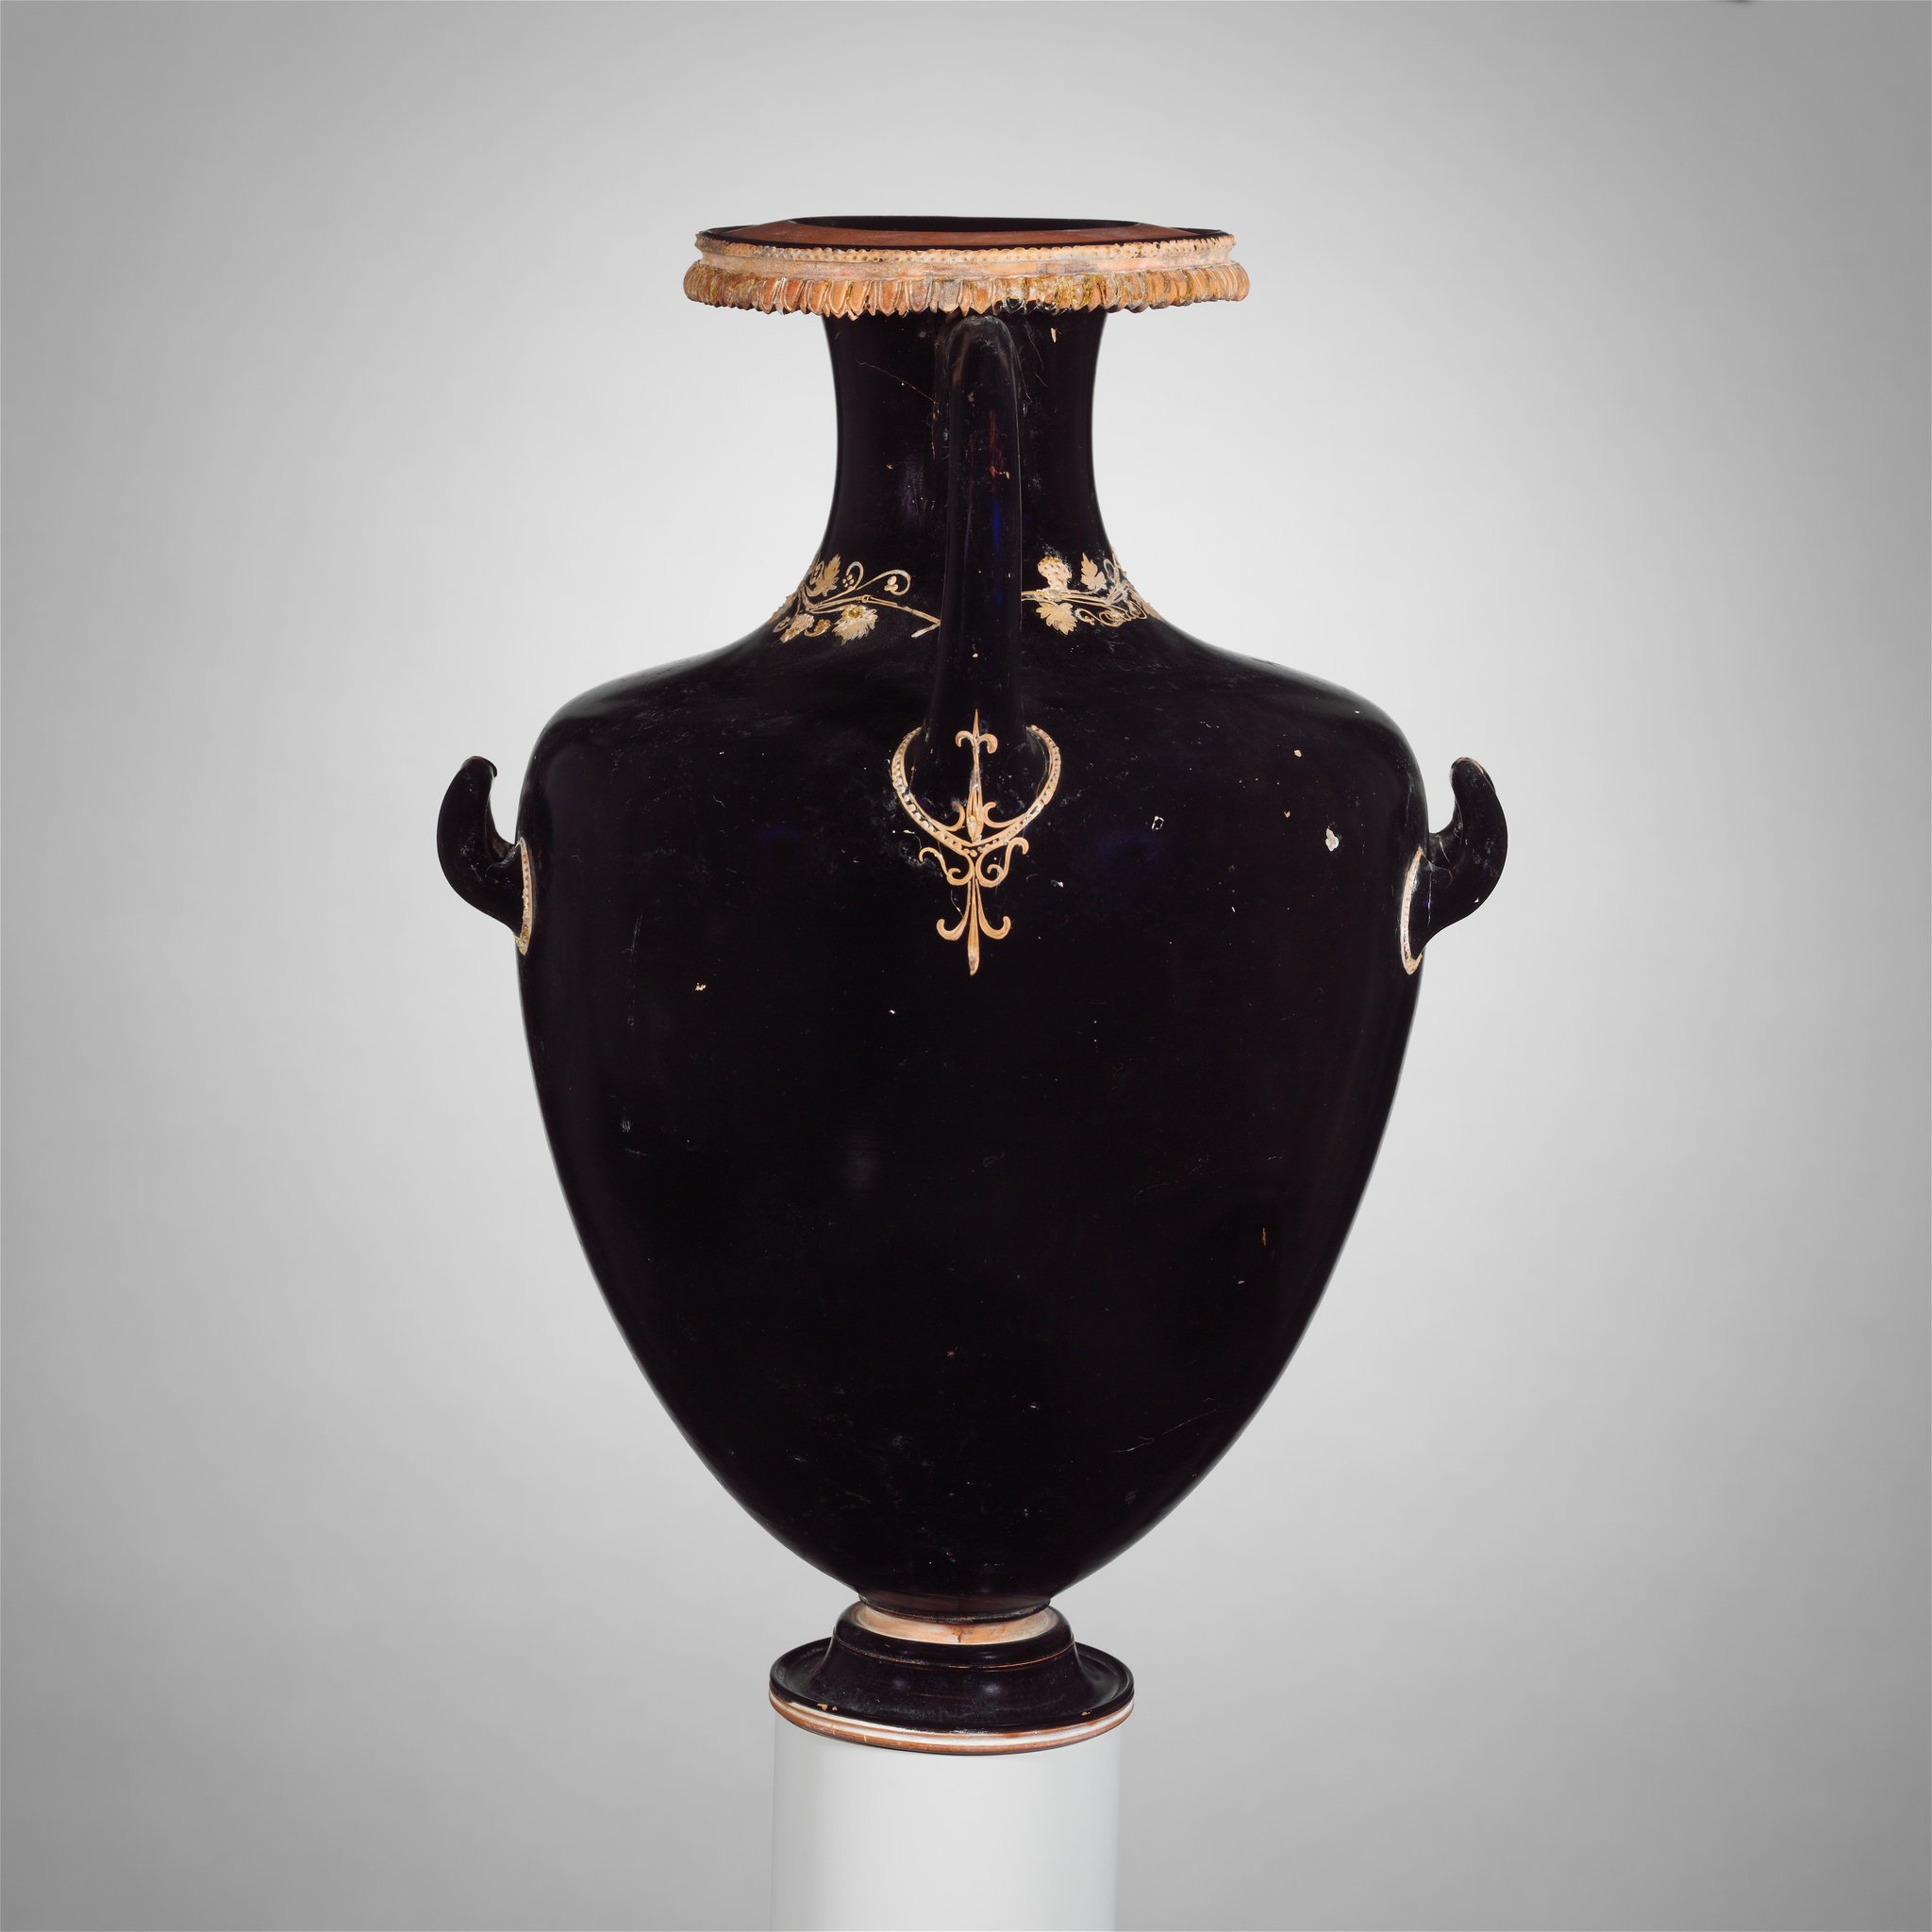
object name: hydria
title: Terracotta hydria (water jar)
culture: greek, attic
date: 400-301 BCE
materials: terracotta